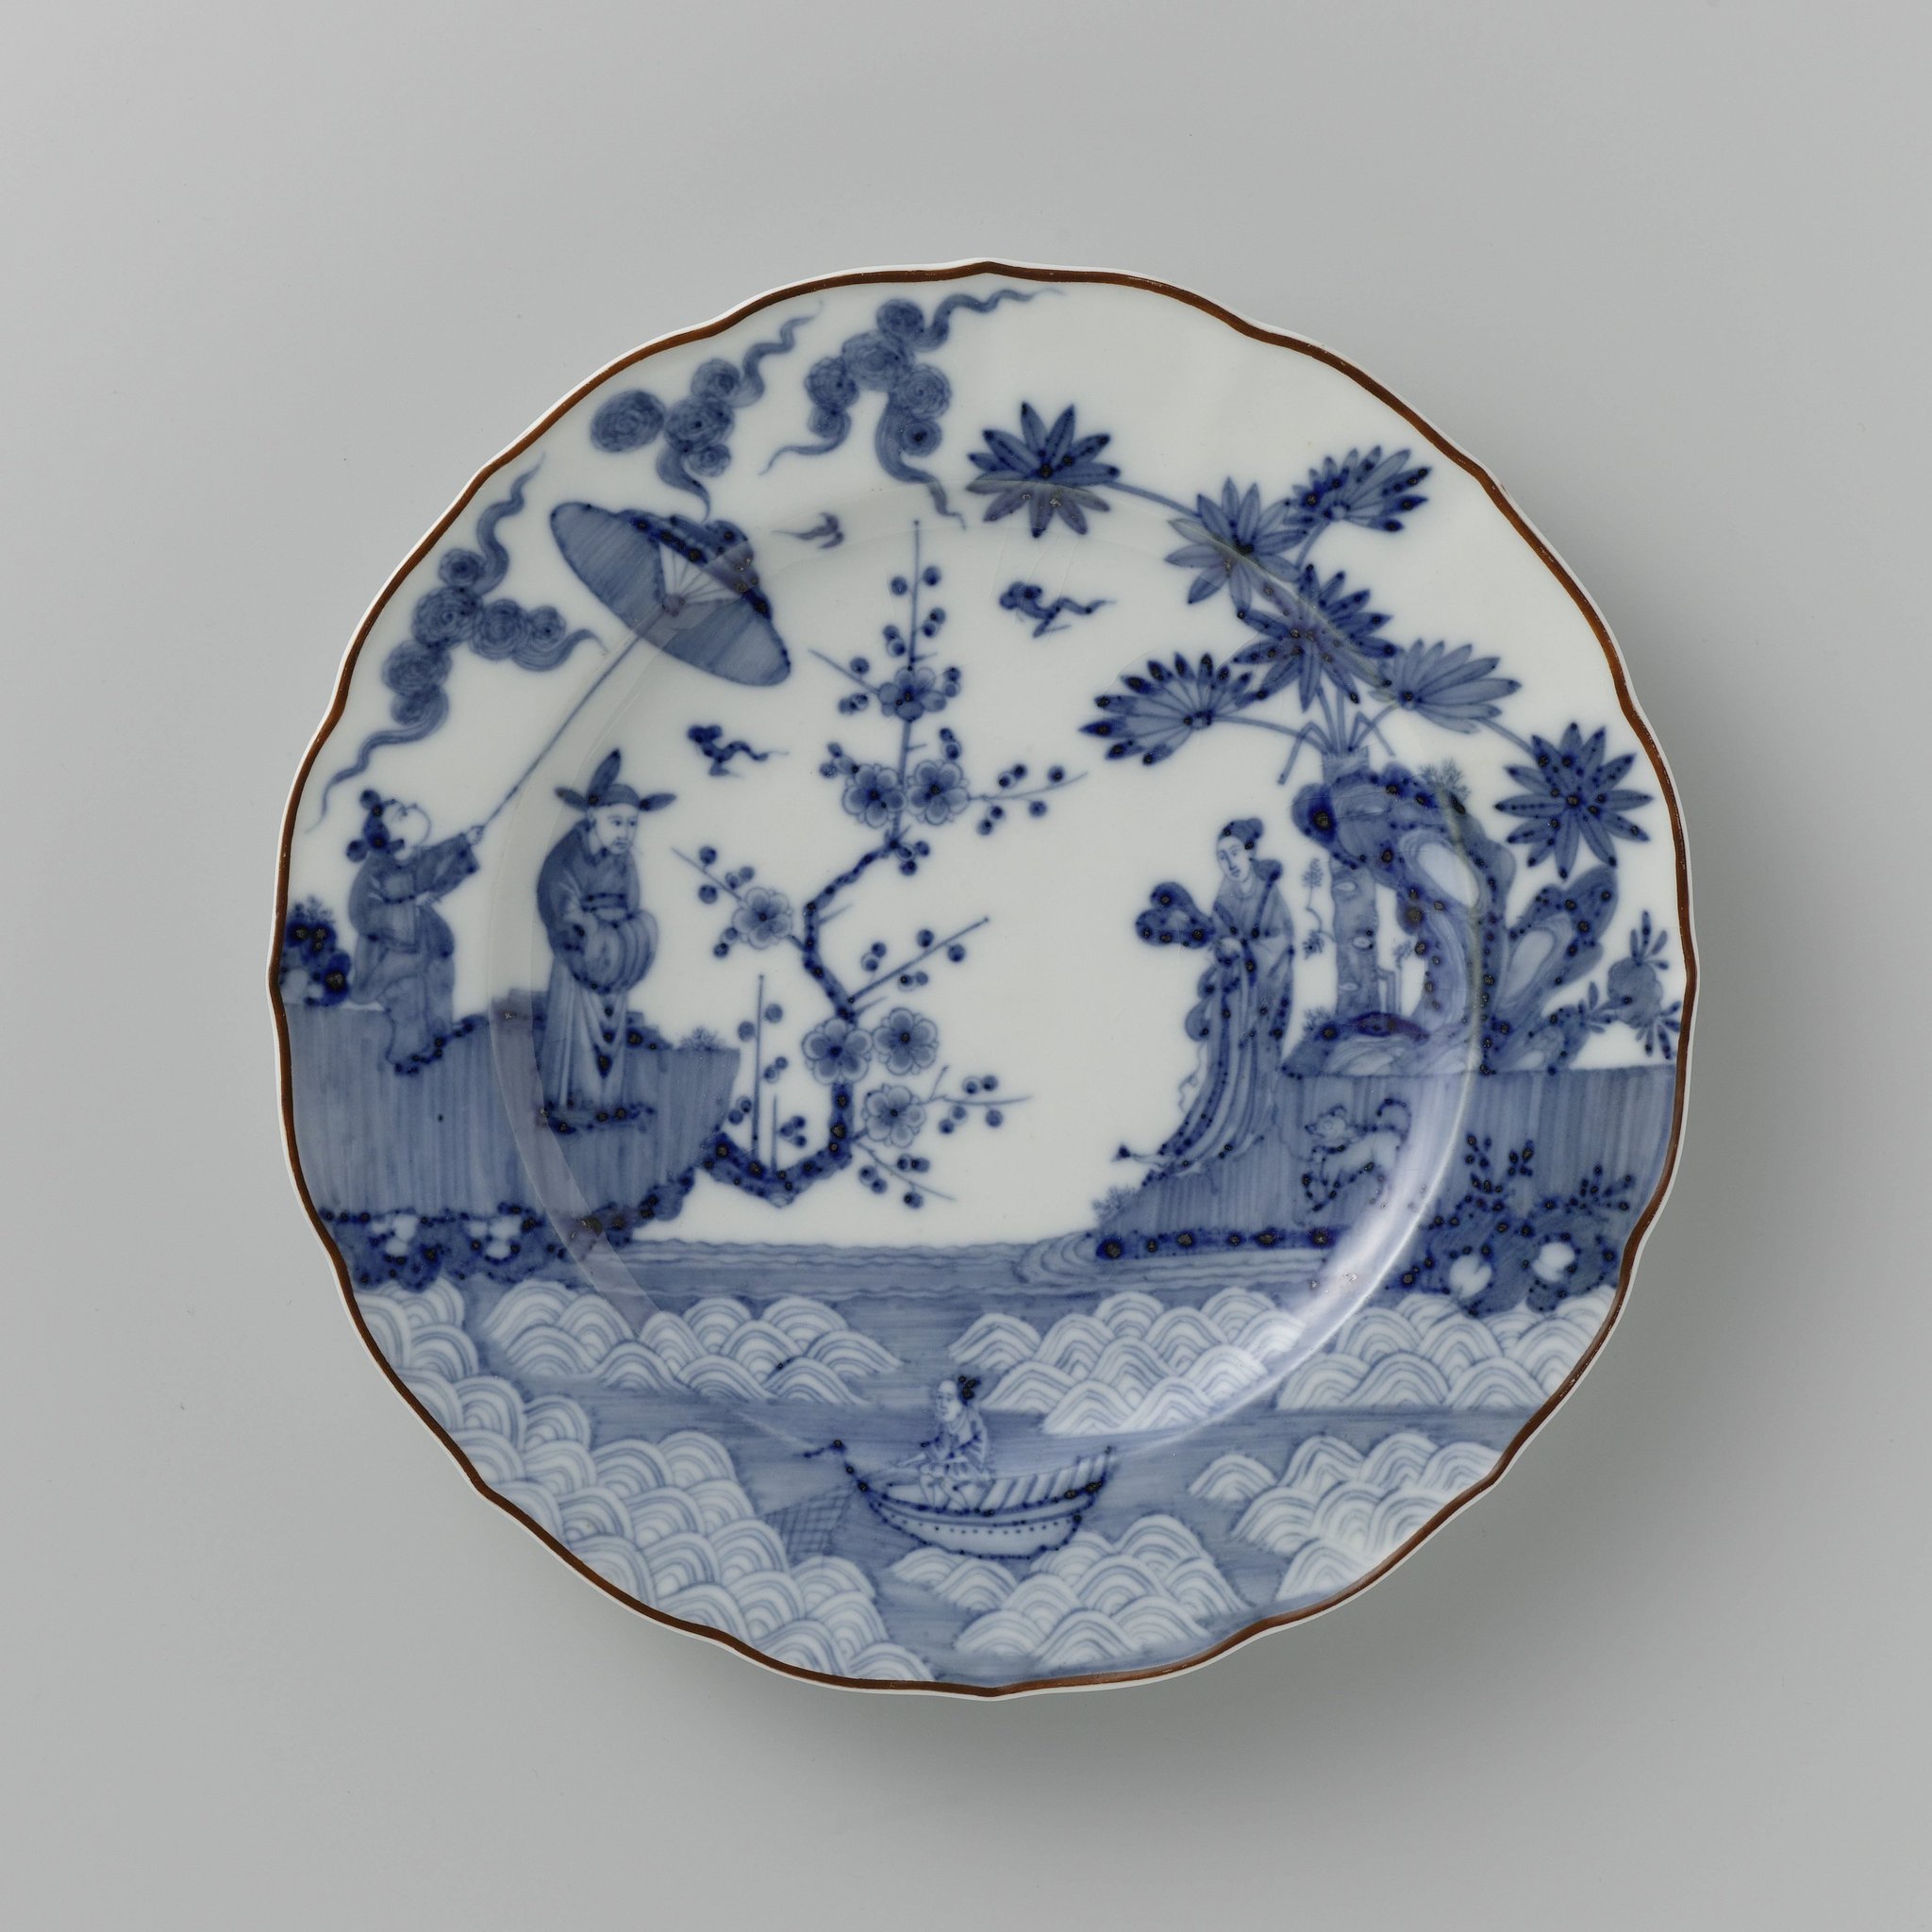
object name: plate dish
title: Plate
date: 1784-1809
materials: porcelain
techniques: painted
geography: ouder-amstel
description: Porceleinfabriek aan den Amstel Manufactuur Oud-Loosdrecht Ouder-Amstel and Loosdrecht, c. 1784–1809 hard-paste porcelain